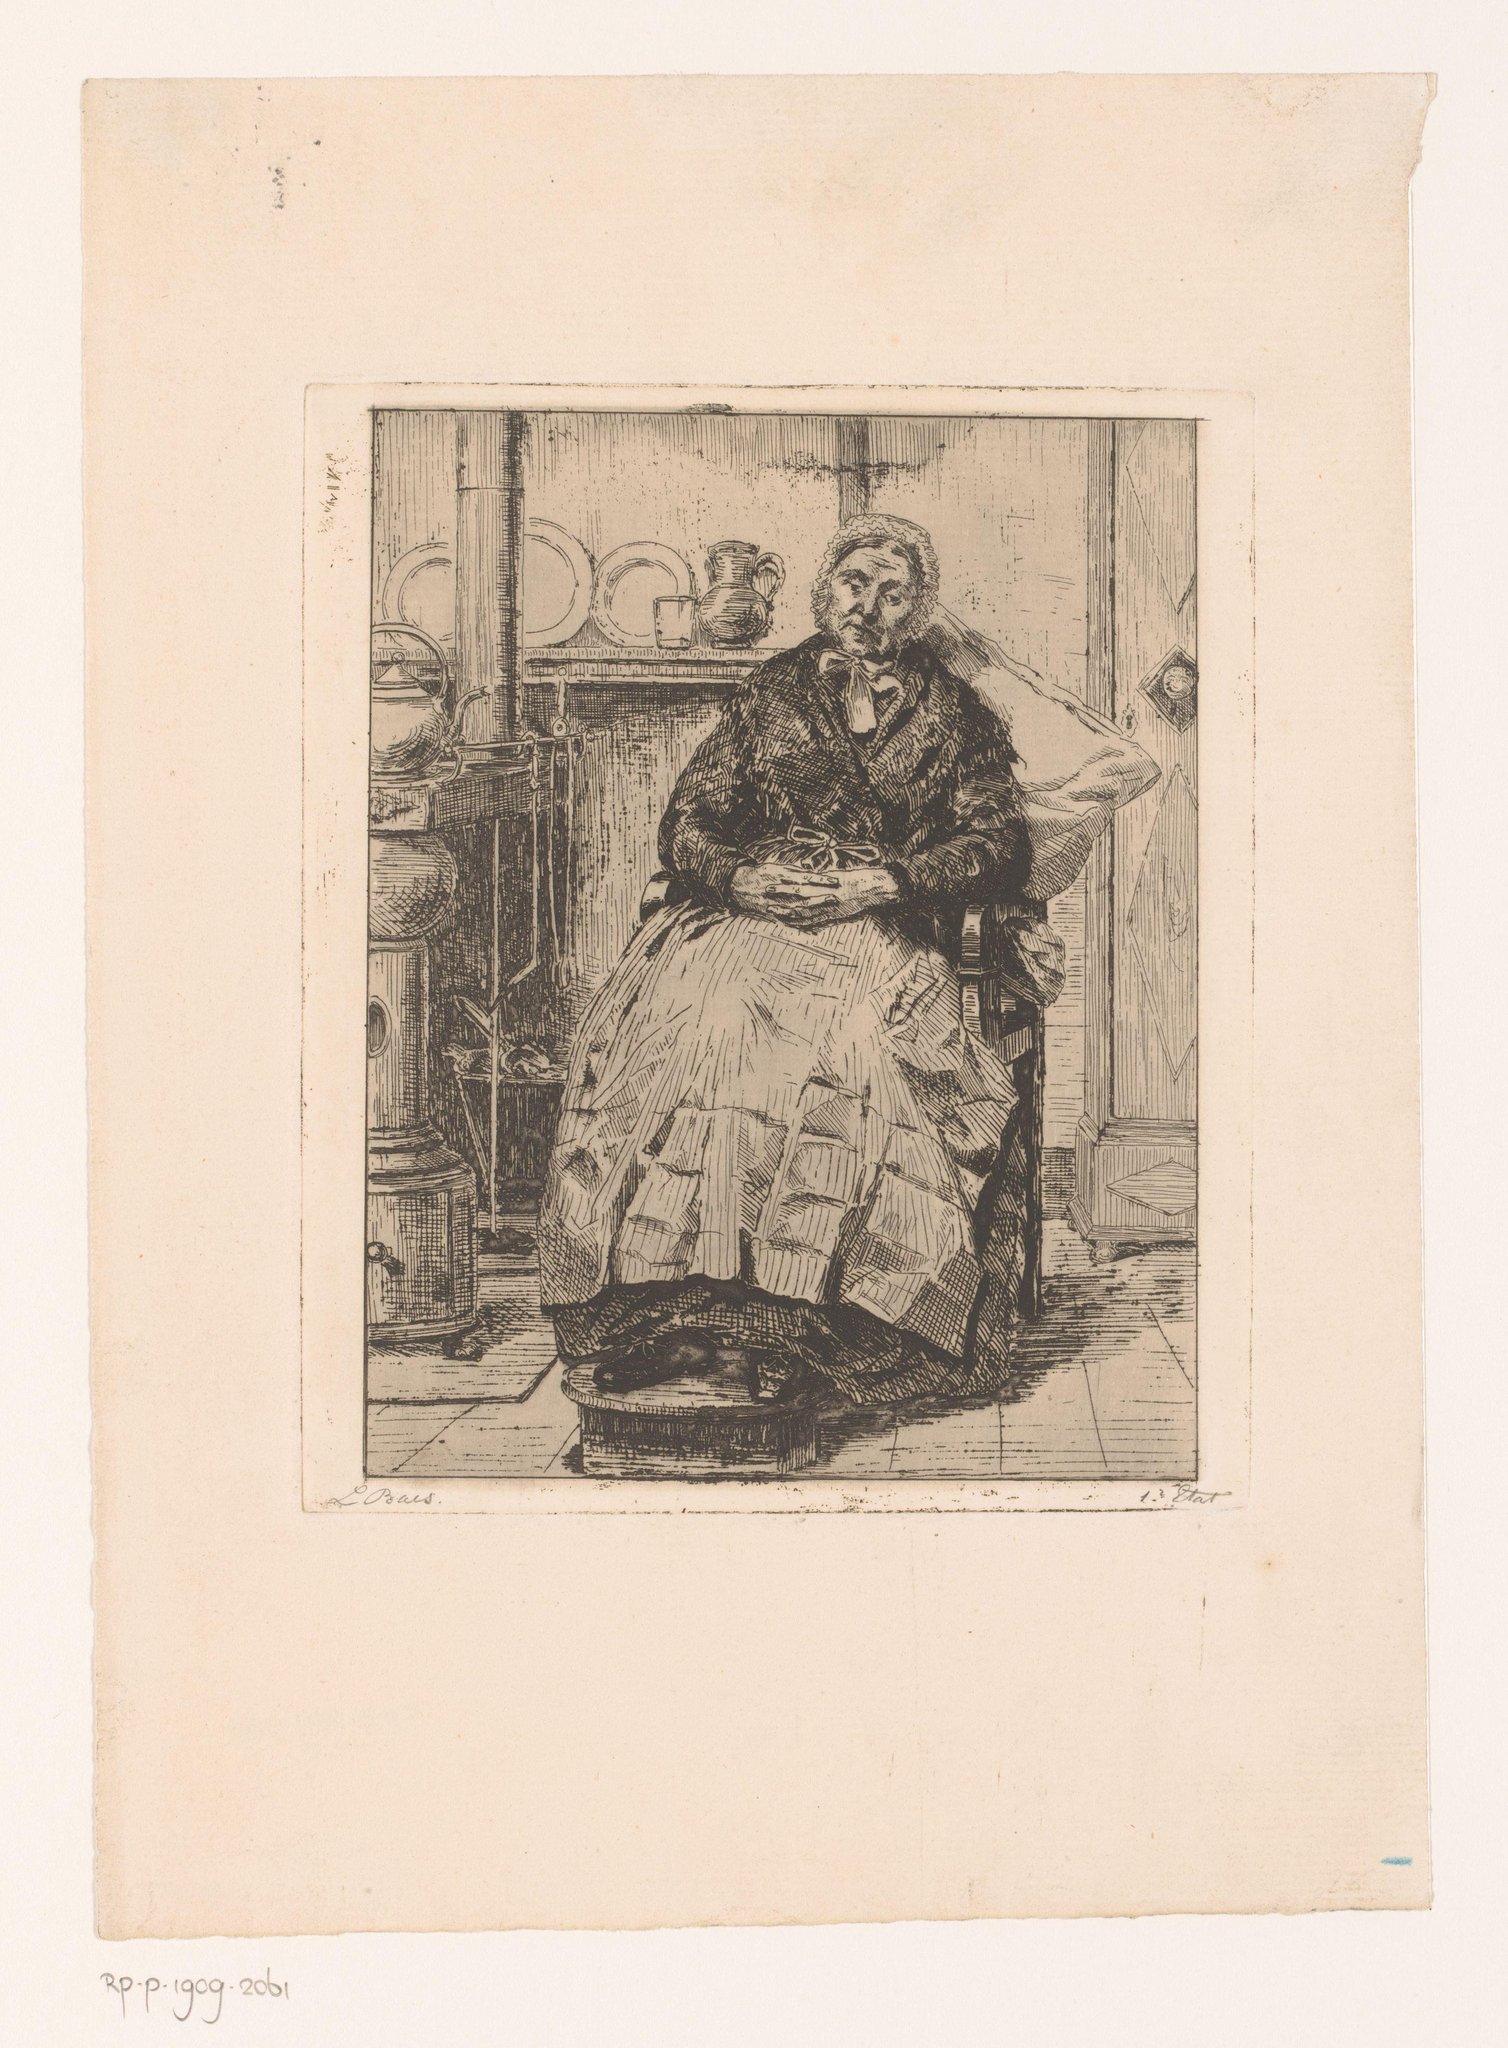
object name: print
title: Oude dame zit comfortabel naast de kachel in de keuken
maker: lionel oscar baes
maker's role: print maker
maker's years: 1839-1913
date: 1849-1909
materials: paper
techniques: drypoint, etching, intaglio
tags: old woman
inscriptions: collector's mark: Lugt 2228, annotation: ‘1. Etat’